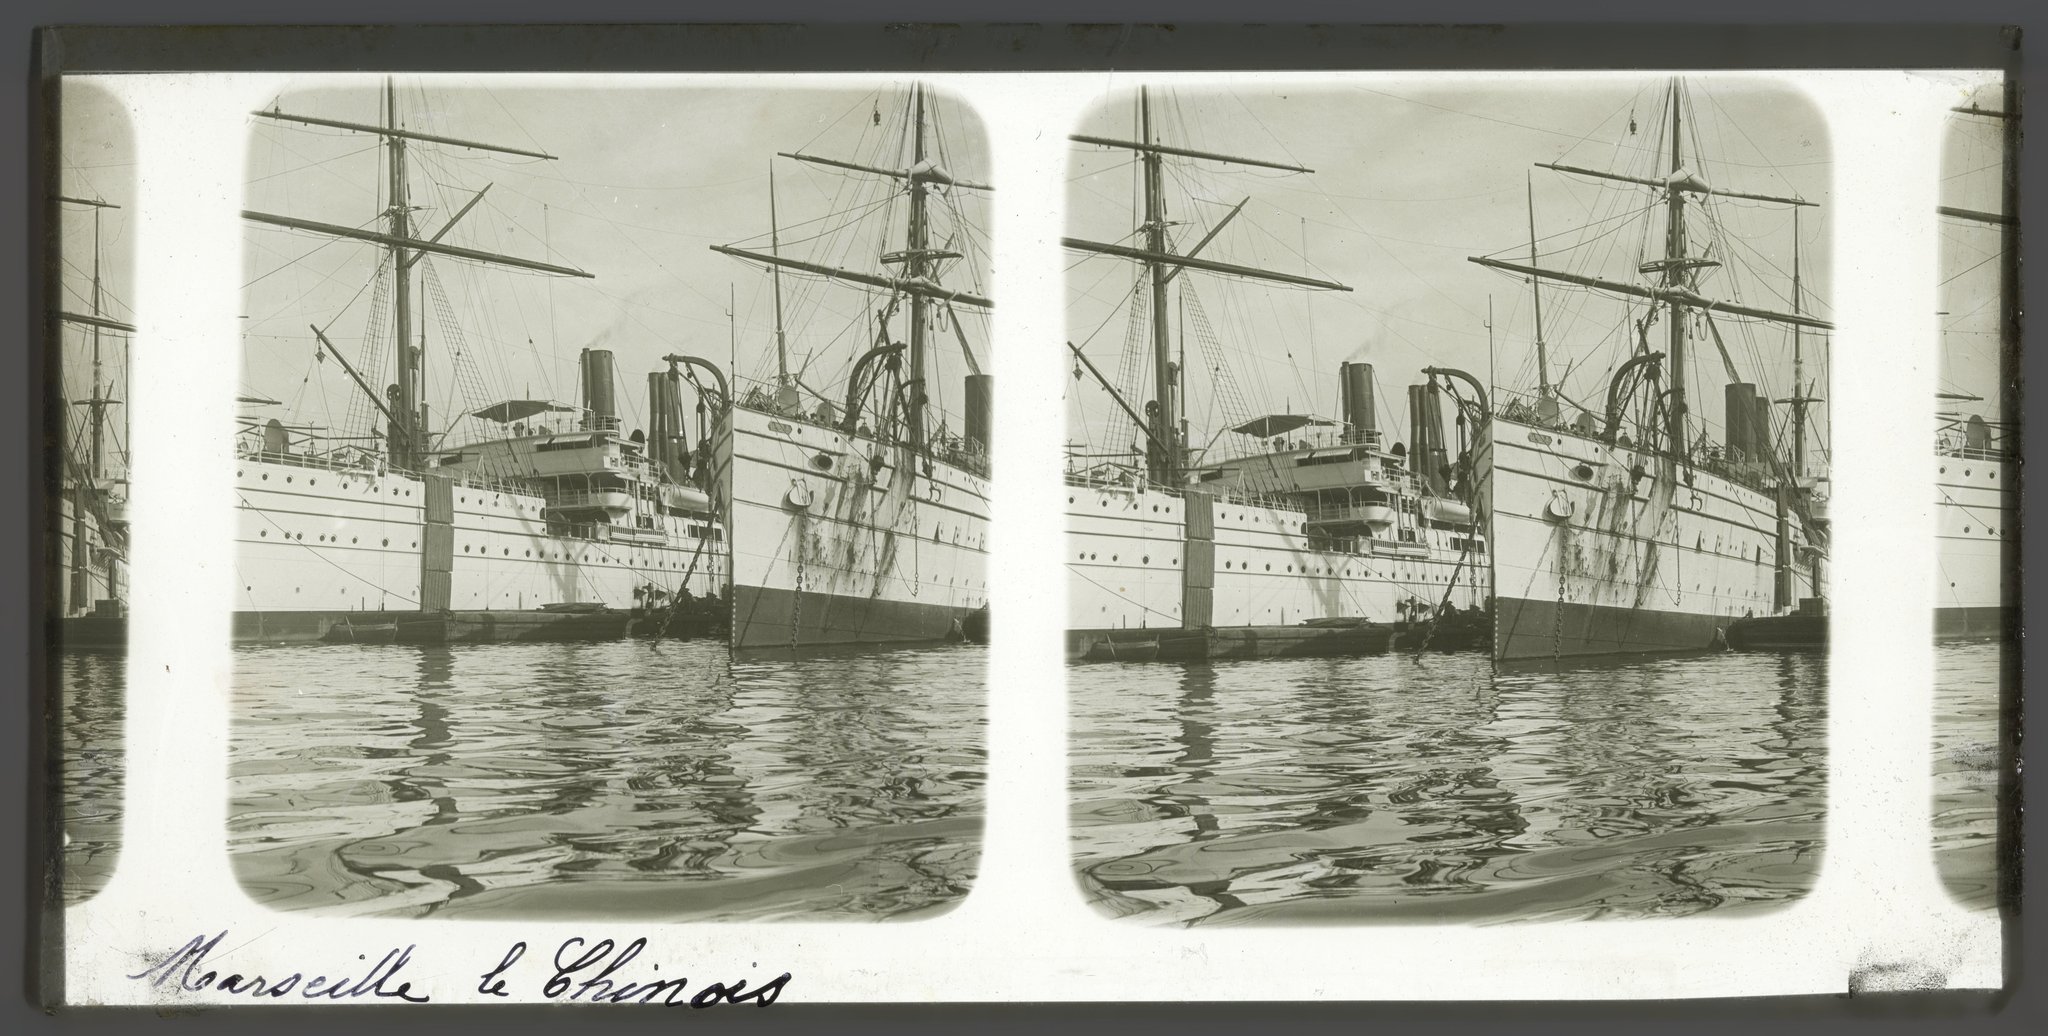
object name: stereoscopic photograph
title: Twee schepen, vermoedelijk in de buurt van Marseille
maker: Anonymous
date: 1860-1890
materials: glass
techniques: slide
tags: ships (in general) - cc - more than one ship